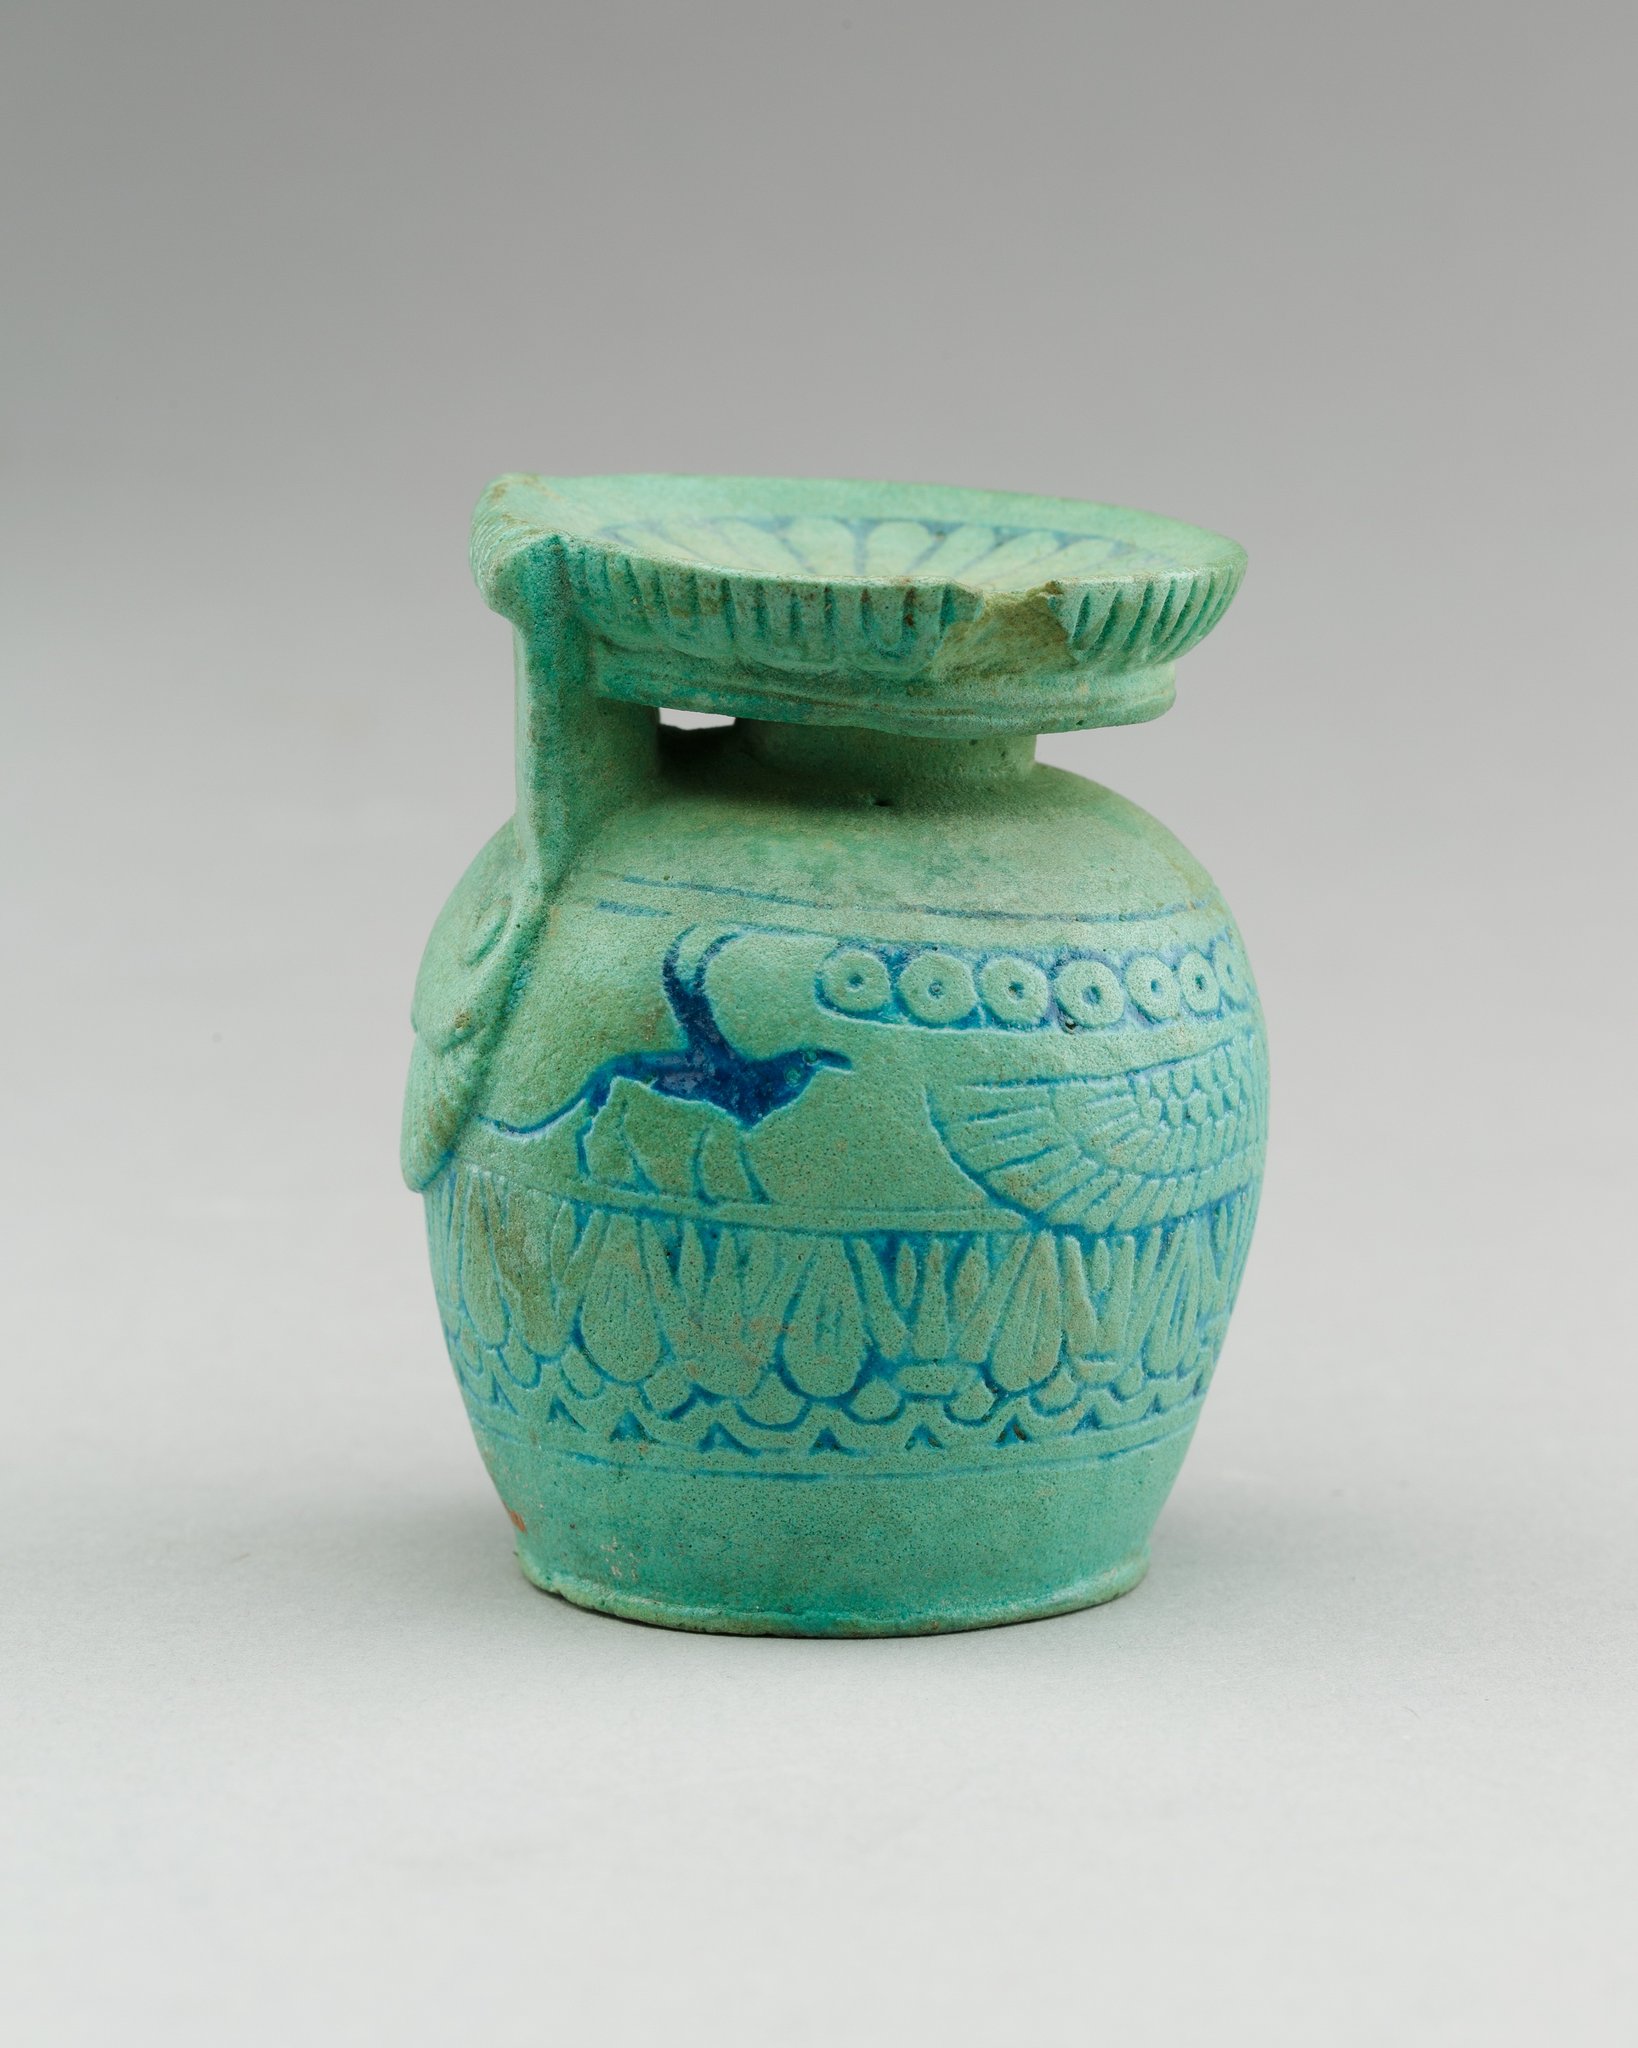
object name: aryballos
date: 550-500 BCE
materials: faience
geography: egypt